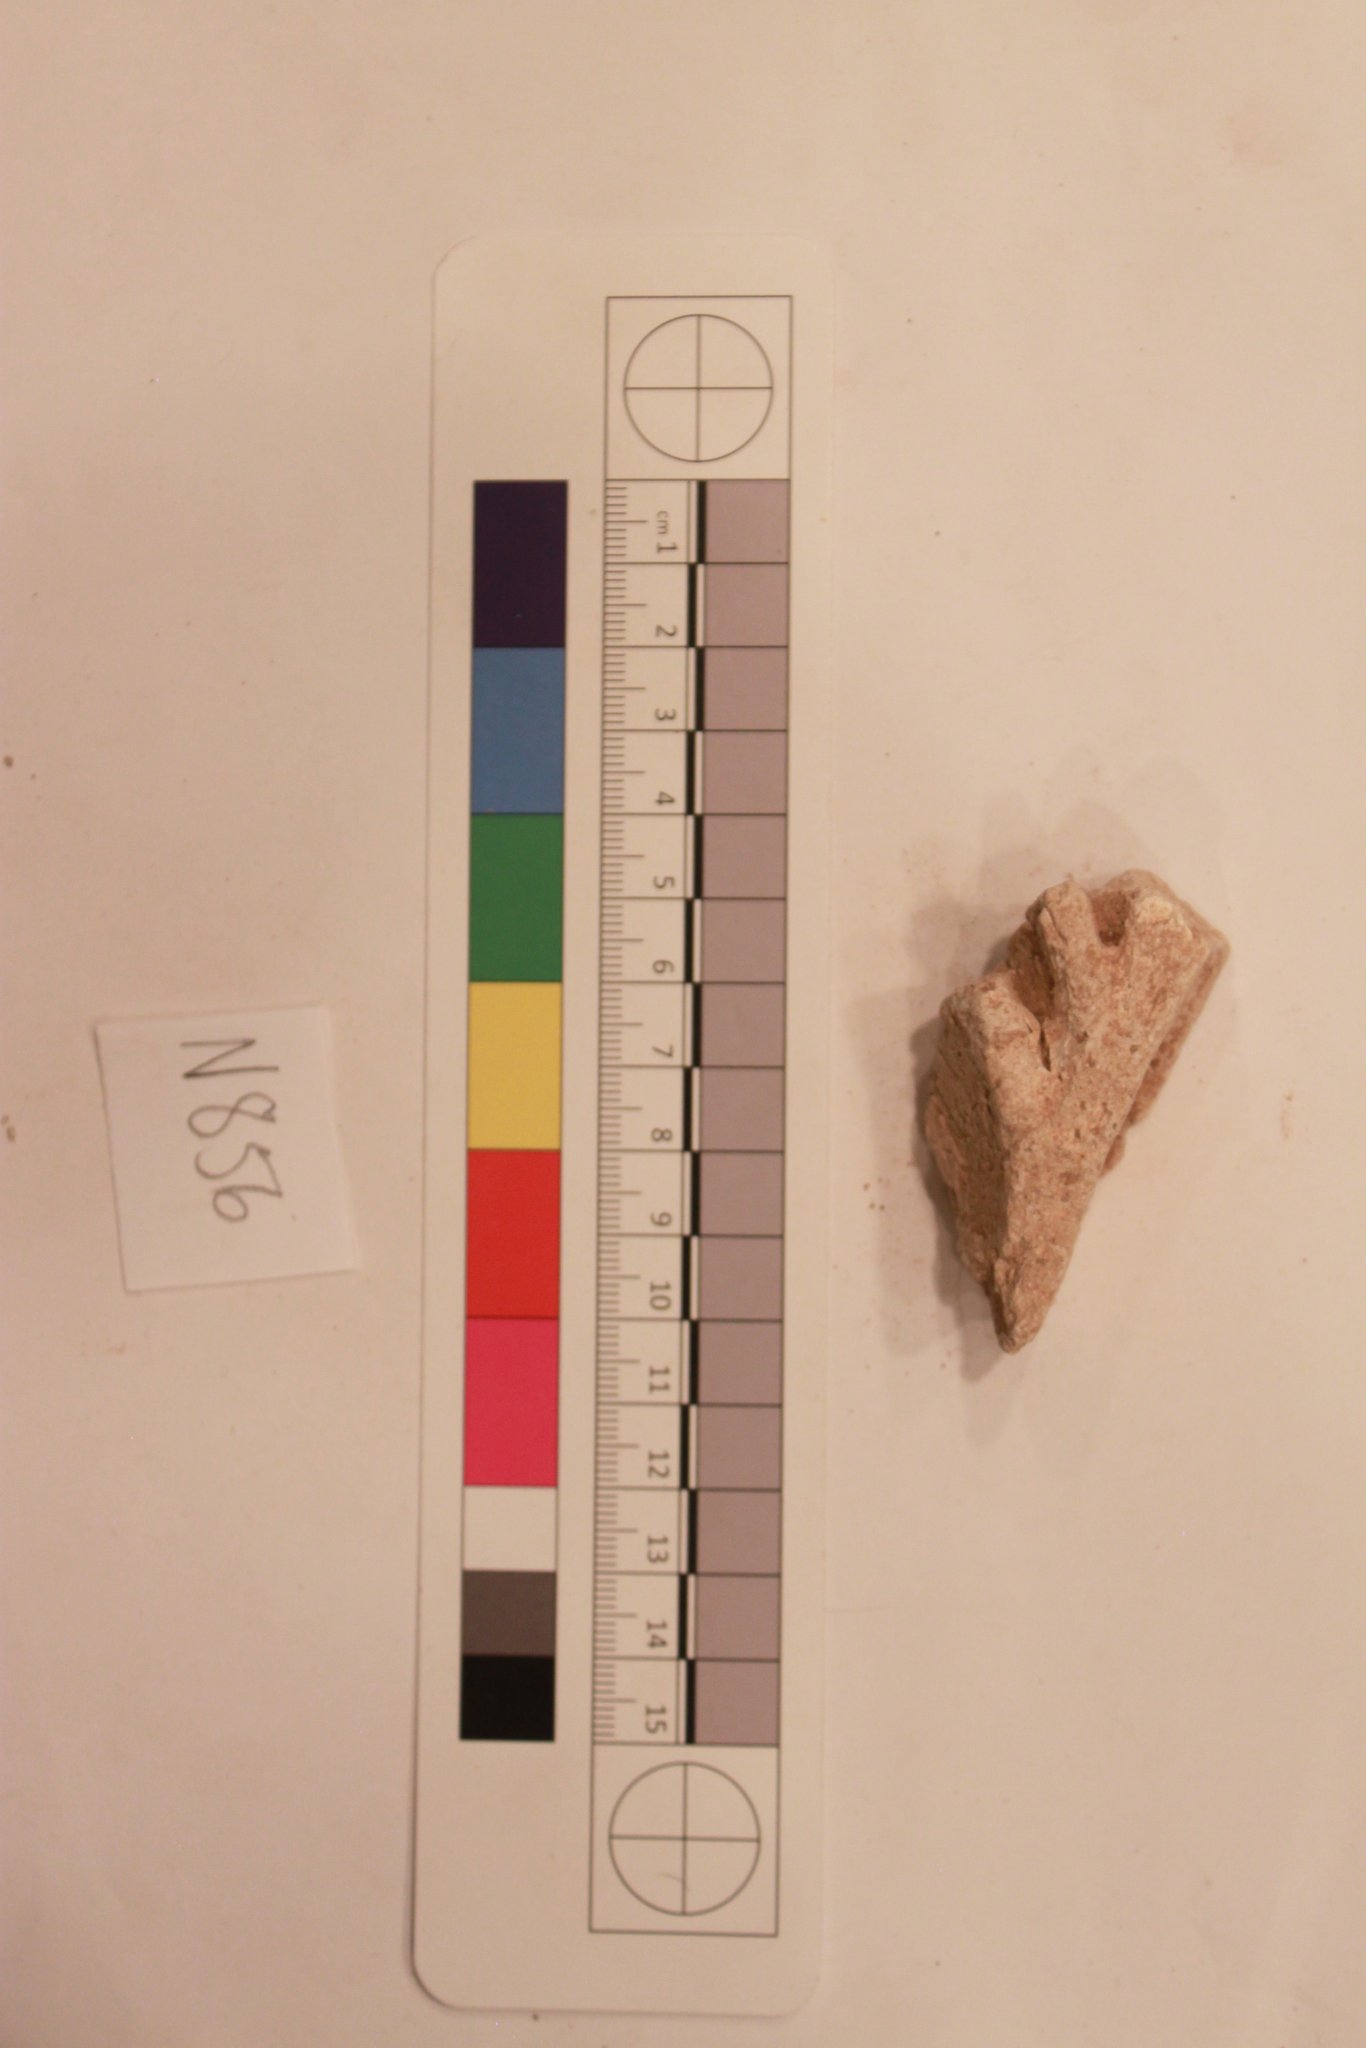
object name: fragment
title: Stucco Fragment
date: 701-1200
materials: plaster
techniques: carving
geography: iran